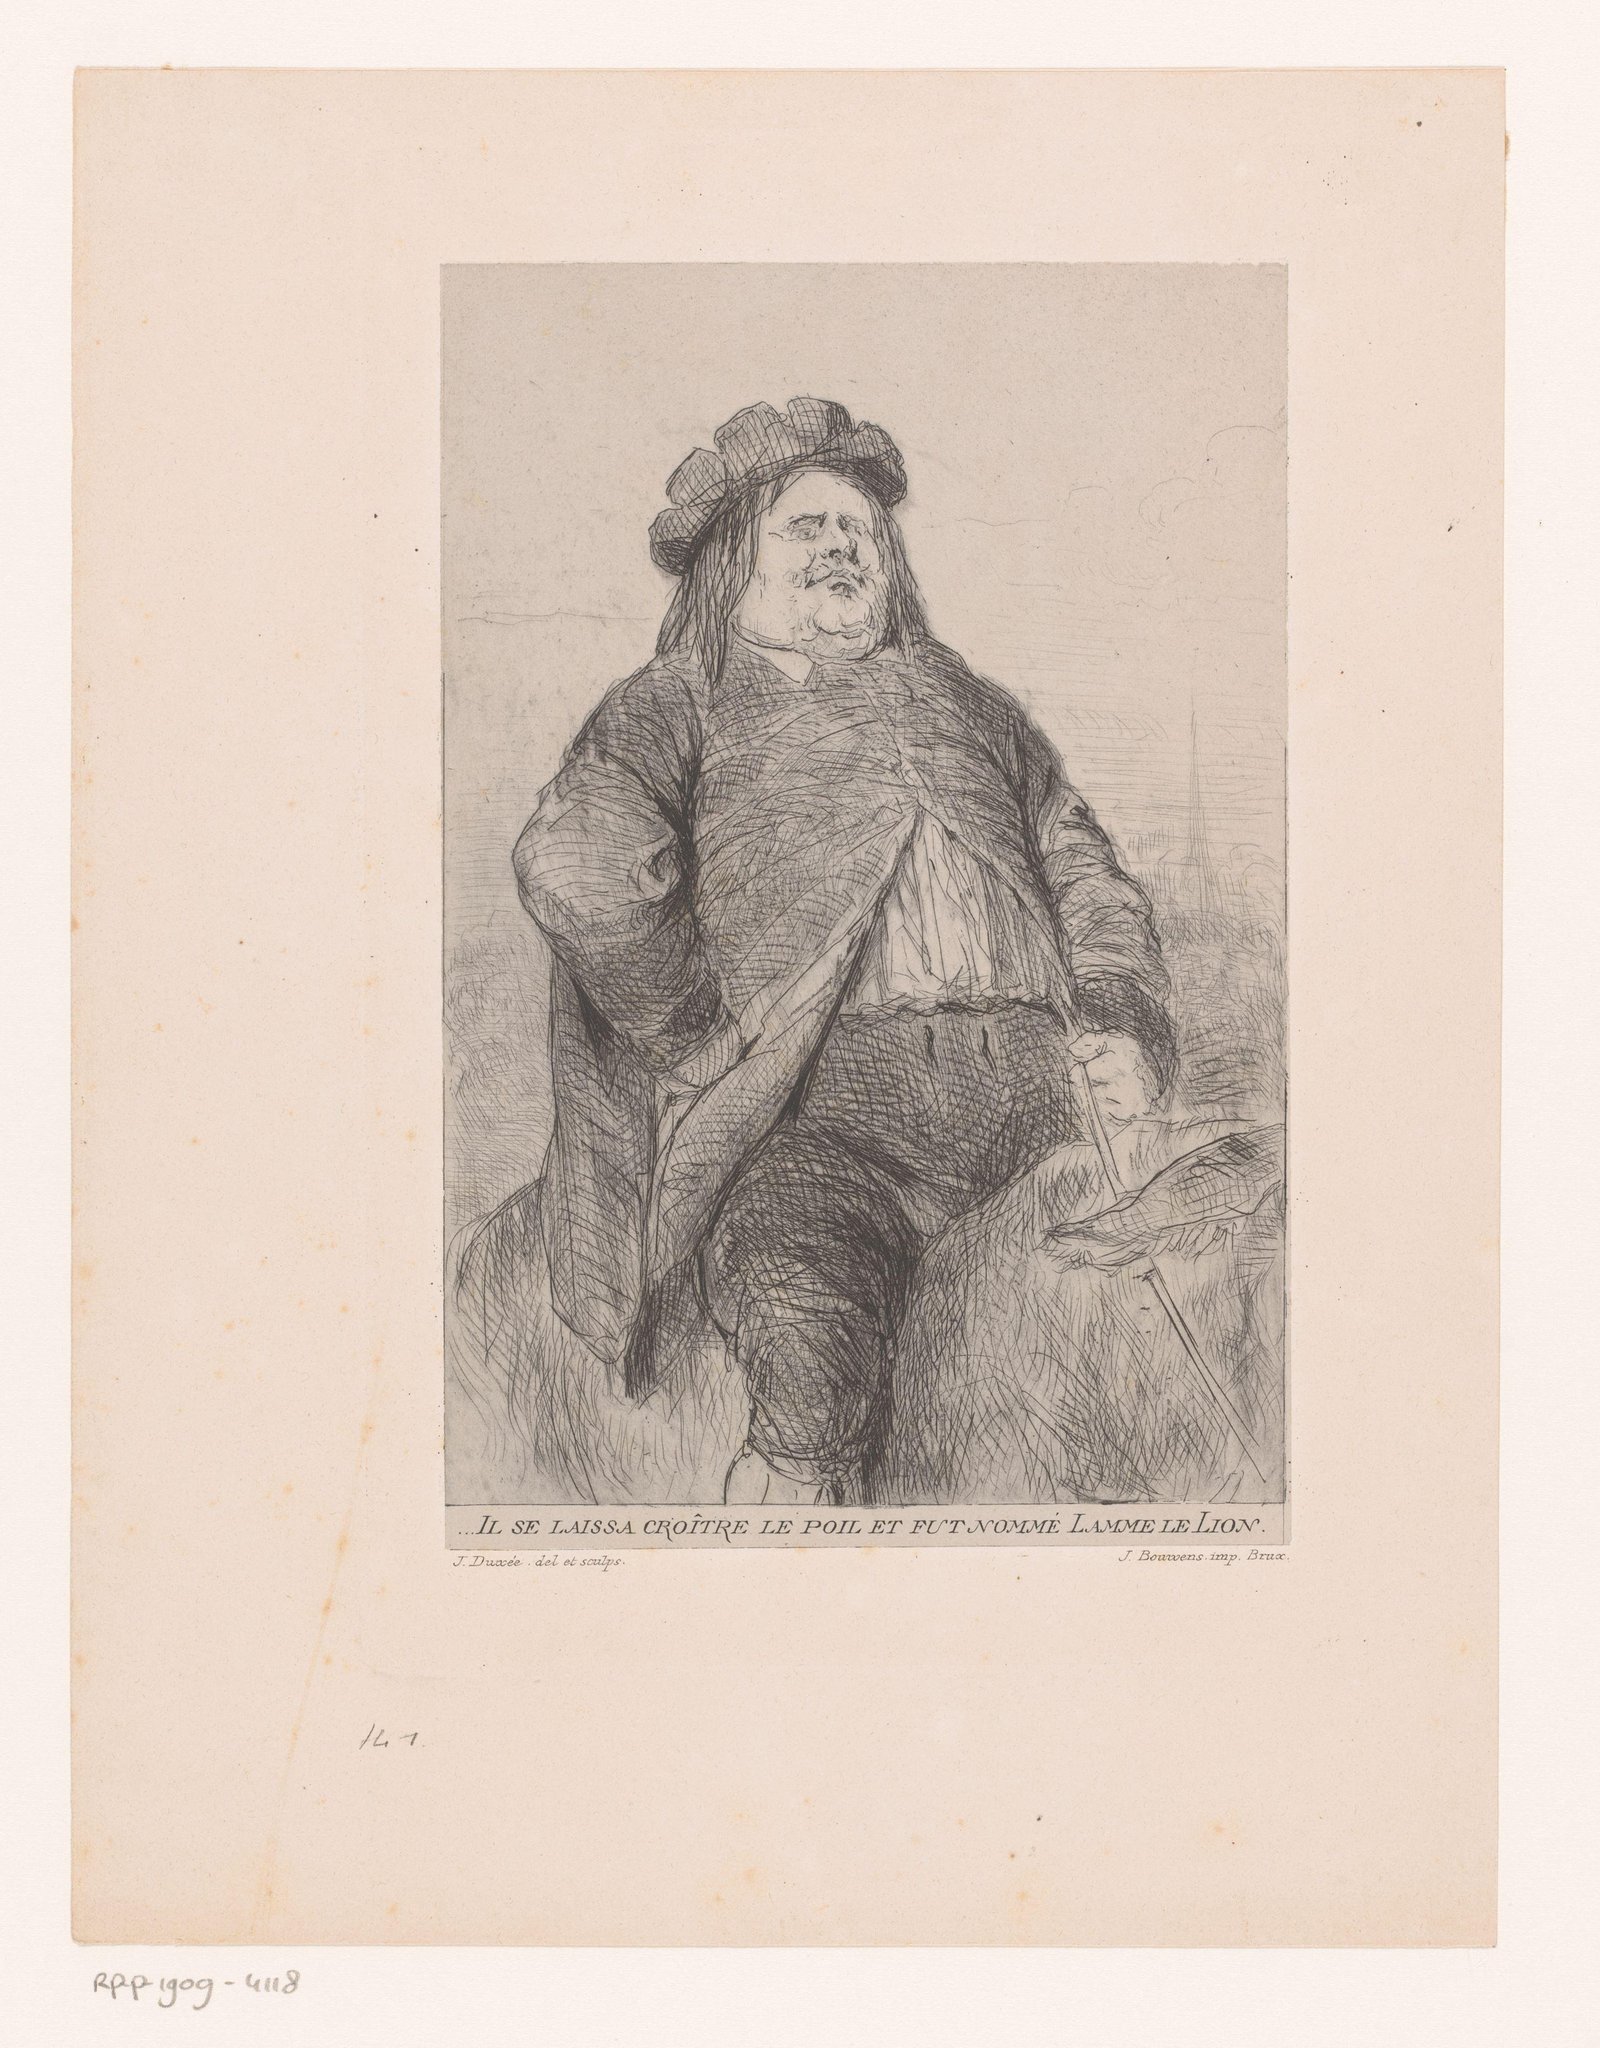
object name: print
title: Lamme Goedzak gezeten op een ezel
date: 1867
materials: paper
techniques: etching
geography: brussels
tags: ass, donkey, adult man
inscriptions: collector's mark: Lugt 2228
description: Prent uit: Coster, Charles de. Le légende et les aventures héroiques, joyeuses et glorieuses d'Ulenspiegel et de Lamme Goedzak au pays de Flandres et ailleurs. Parijs: s.n., [1867].